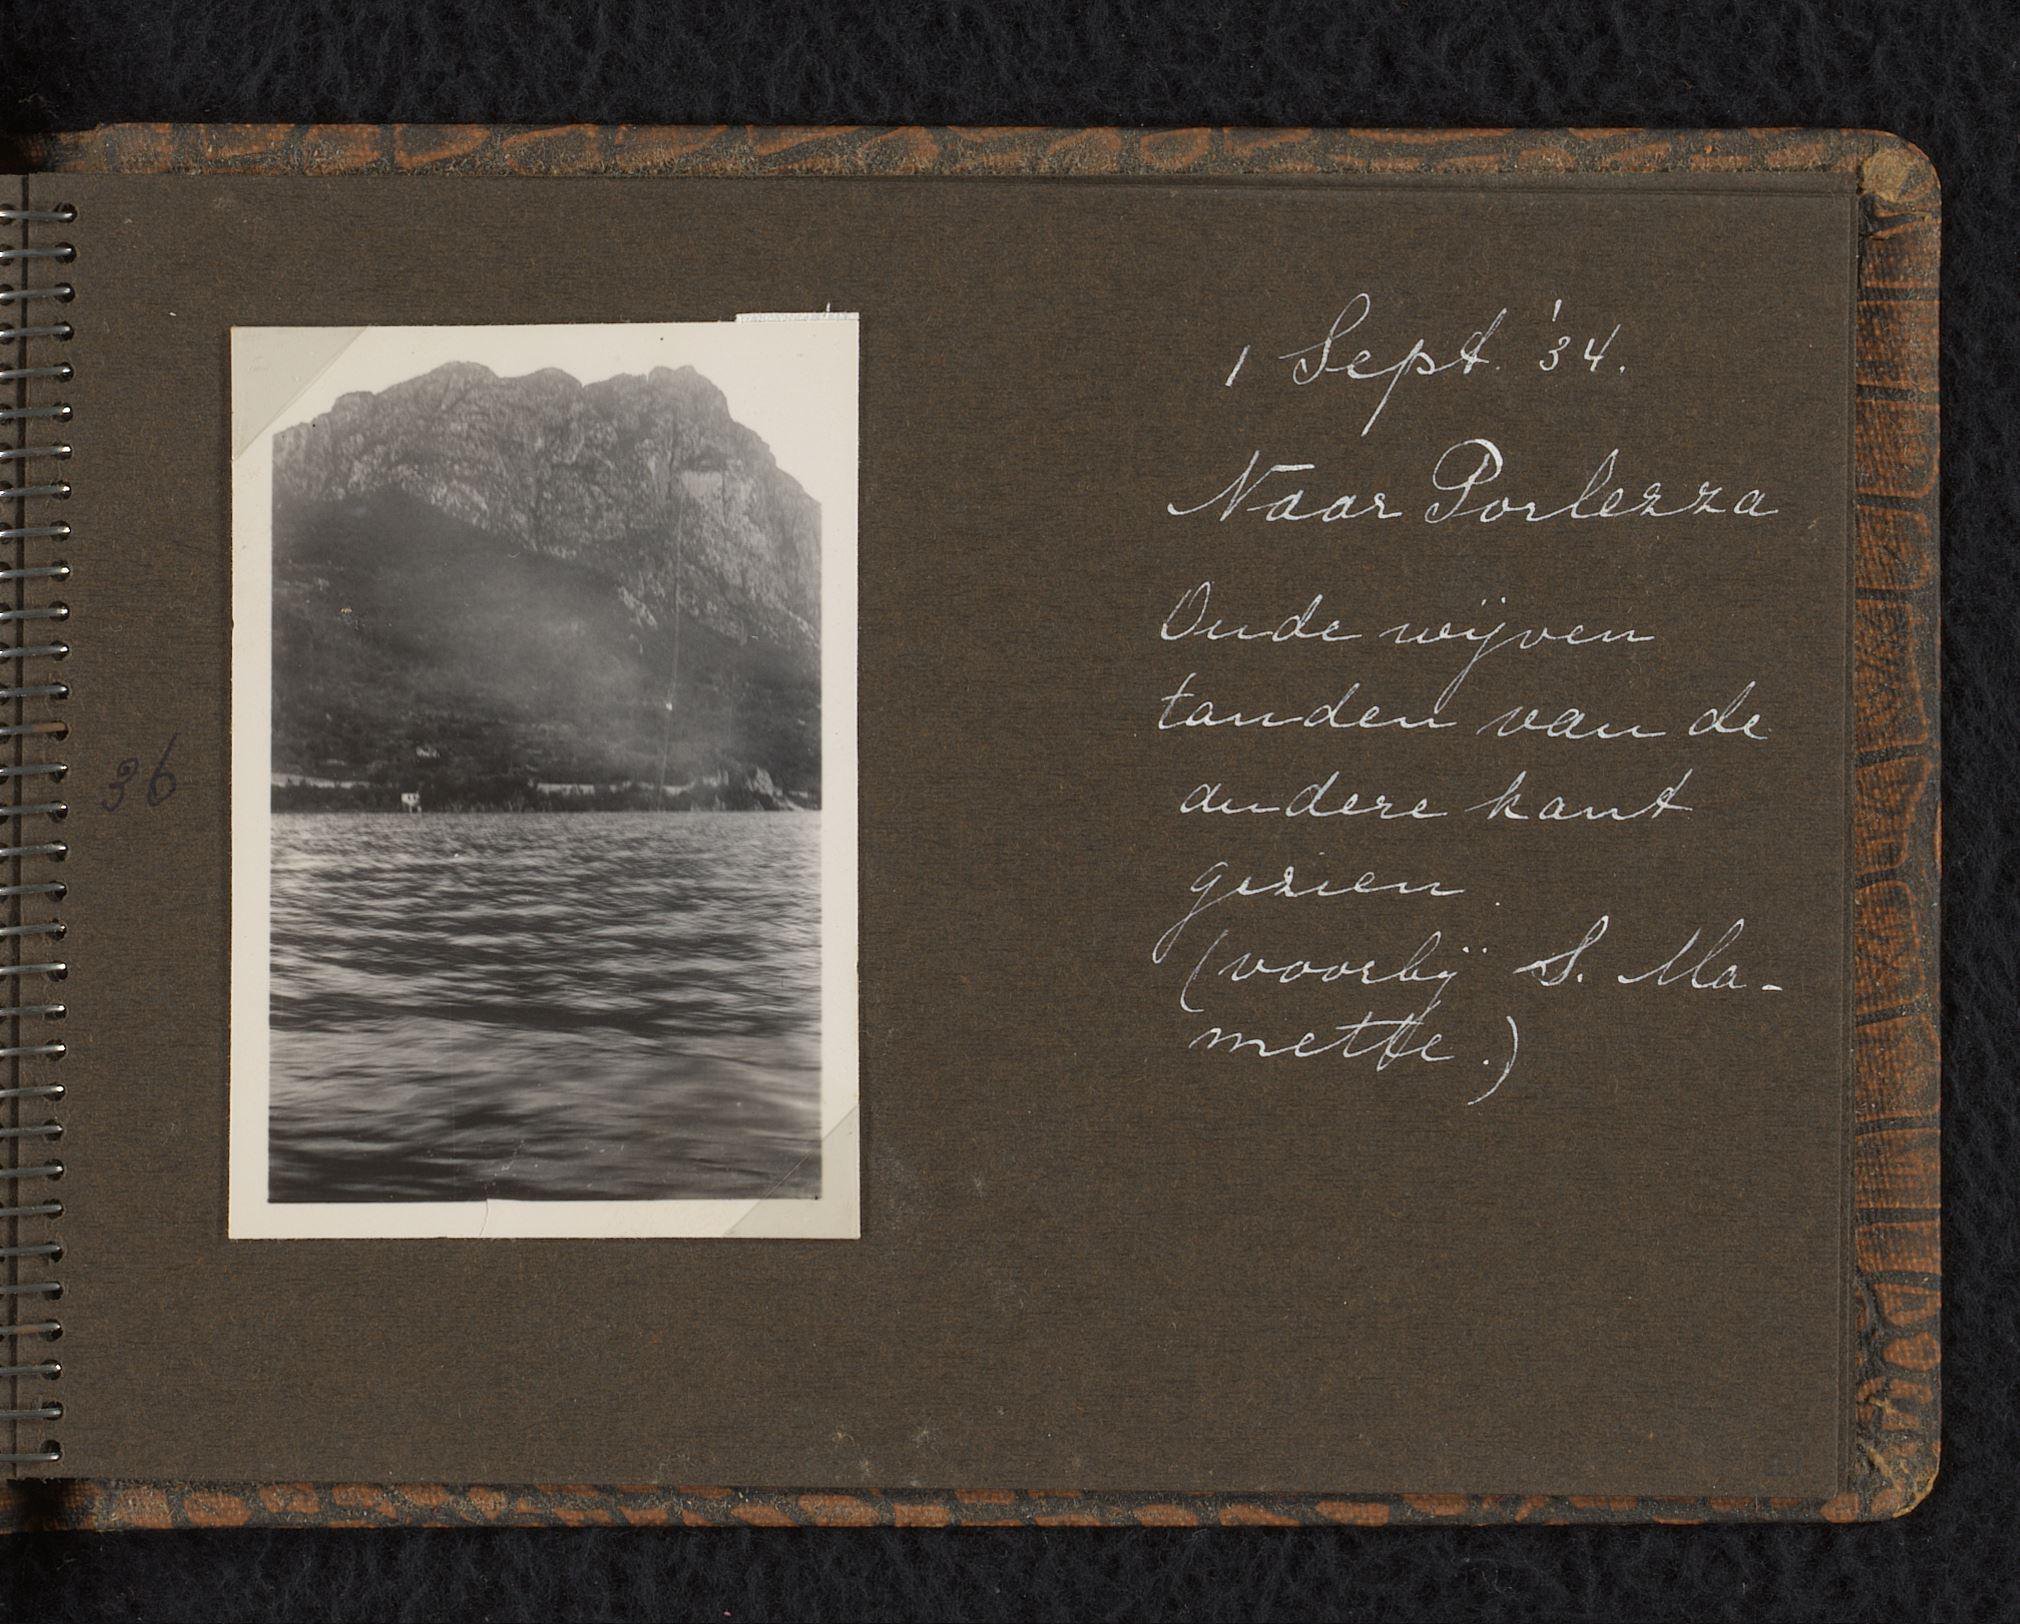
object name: photograph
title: Naar Porlezza. Oude wijven tanden van de andere kant gezien (voorbij S. Mamette)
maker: Anonymous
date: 1934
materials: paper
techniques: gelatin silver print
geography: lake lugano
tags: lake, mountains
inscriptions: number: ‘36’